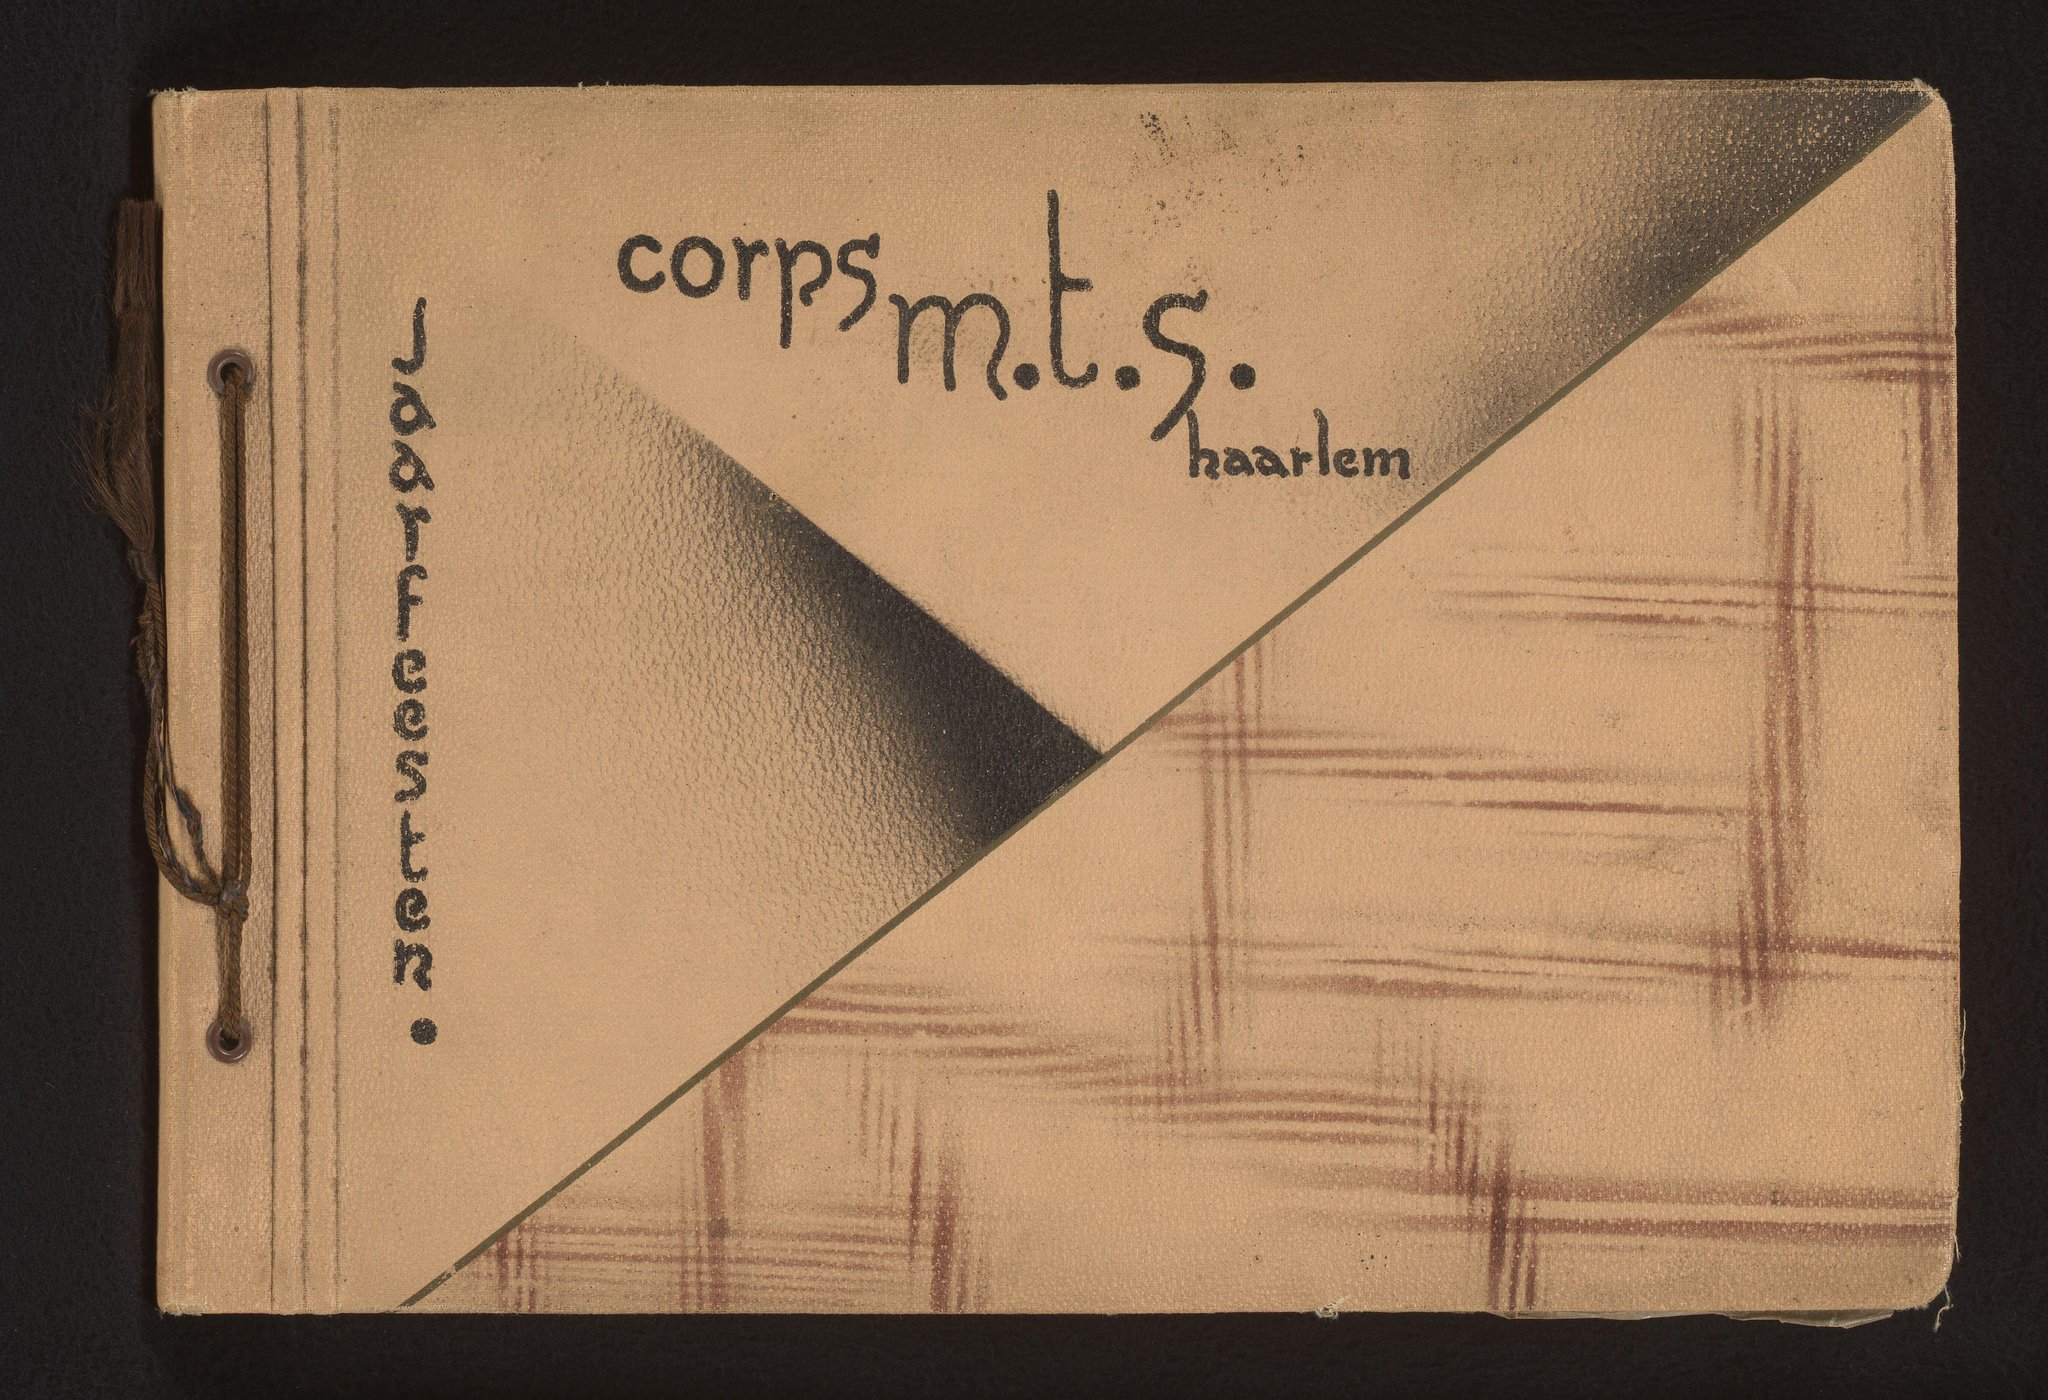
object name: scrapbook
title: Jaarfeesten corps m.t.s. haarlem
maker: Anonymous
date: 1902-1936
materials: linen, paper, photographic support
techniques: gelatin silver print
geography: haarlem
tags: vocational education, e.g.: junior technical school, student life, haarlem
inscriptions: inscription: ‘corps m.t.s. haarlem // jaarfeesten.’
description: Fotoalbum met beige omslag van linnen met kunststof met versiering en opschrift. Het album bevat 24 bladen van bruin papier met pergamijn tussenbladen met in totaal 25 foto's. Bijn alle foto's betreffen de opvoering van het toneelstuk 'Wat Jonas overkwam' door het corps van leerlingen van de Haarlemse MTS van 1935-1936 in het Stadsschouwburg te Haarlem op 22 februari 1936. Behalve foto's bevat het album ook krantenartikelen over het toneelstuk. Achterin twee losse latere foto's in mapjes.